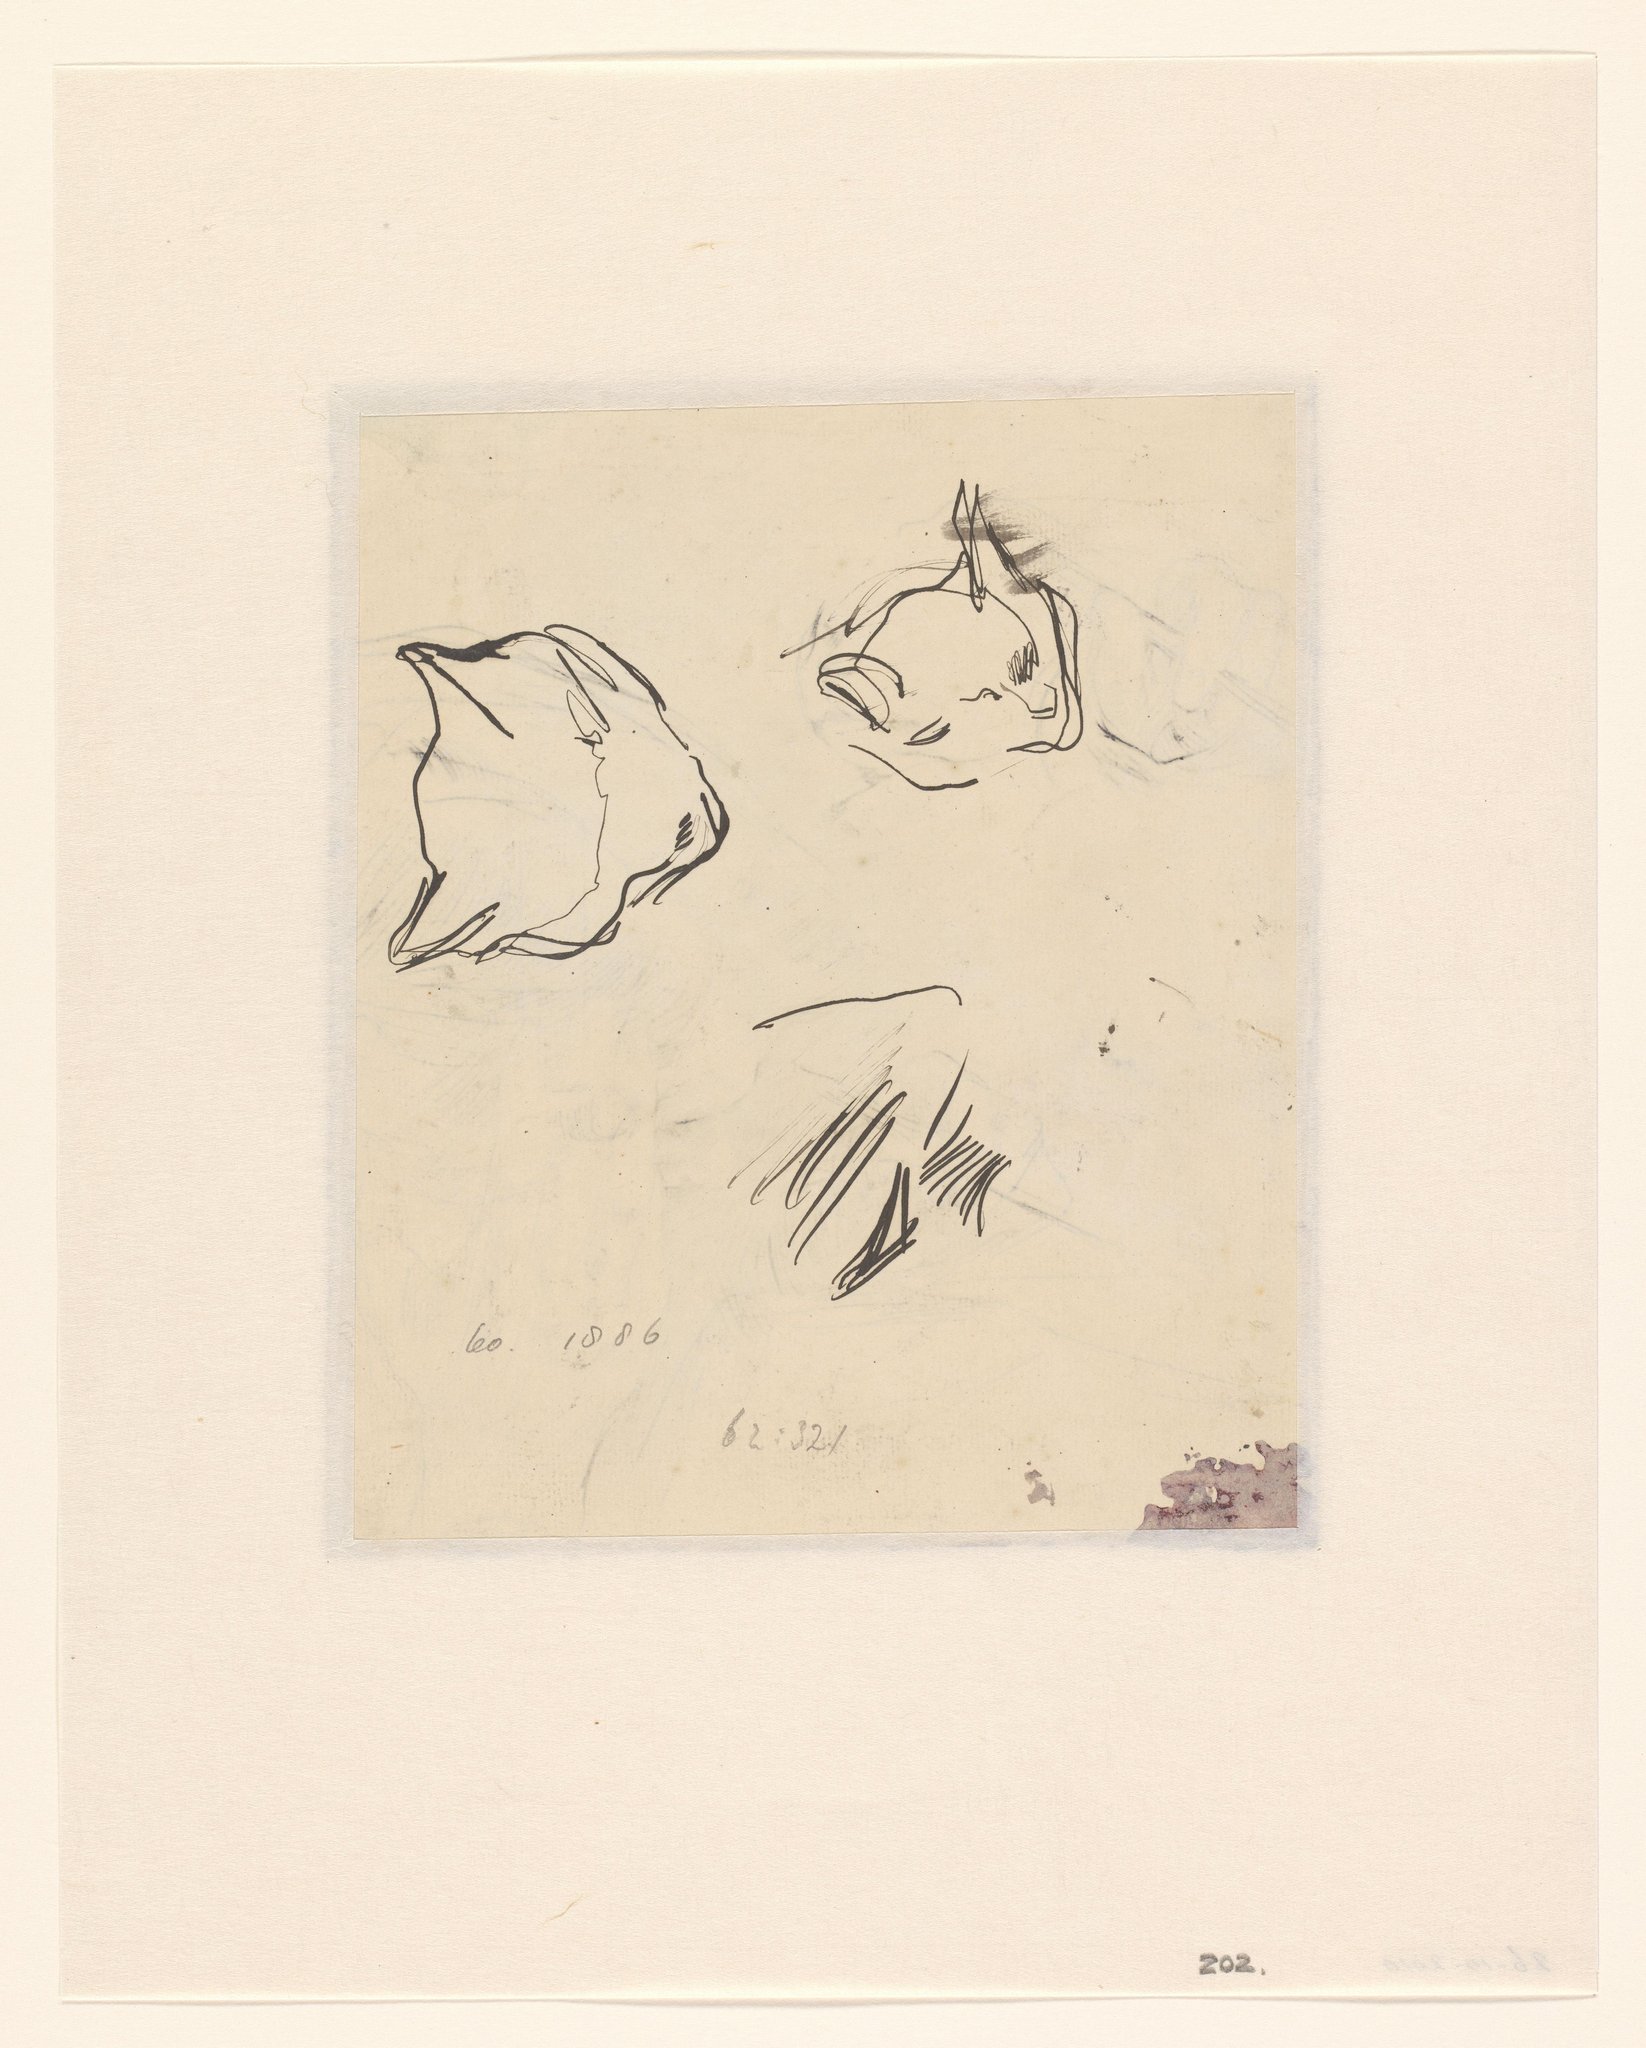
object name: drawing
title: Schetsen van een kat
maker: jan veth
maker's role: designer, draughtsman, painter, print maker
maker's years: 1864-1925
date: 1874-1925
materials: ink, paper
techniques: pen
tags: cat